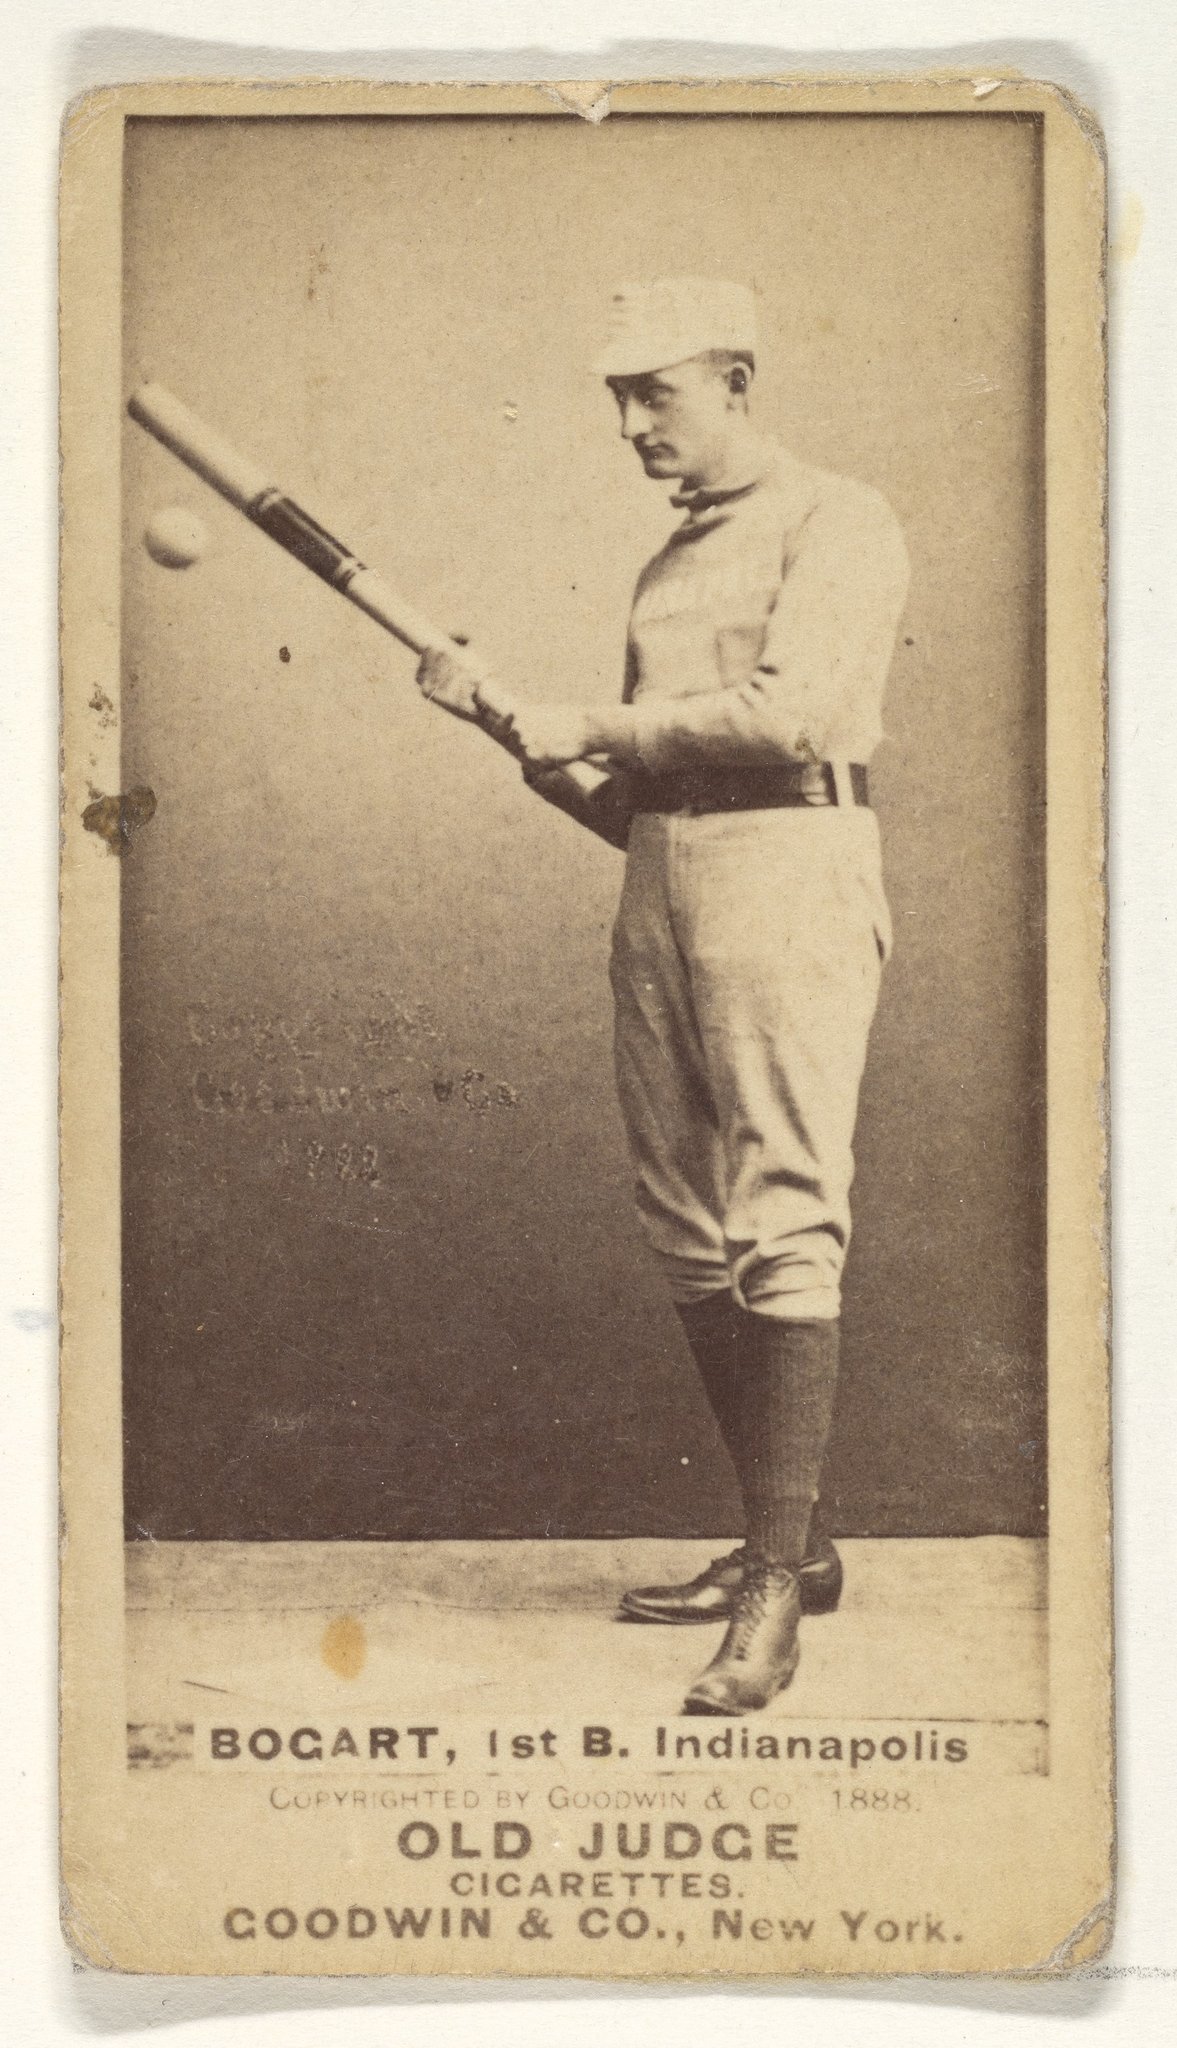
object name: baseball card, photograph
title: Bogart, 1st Base, Indianapolis, from the Old Judge series (N172) for Old Judge Cigarettes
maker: goodwin & company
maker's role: publisher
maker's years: 1850-1950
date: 1888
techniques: albumen silver print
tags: men,portraits,baseball,athletes